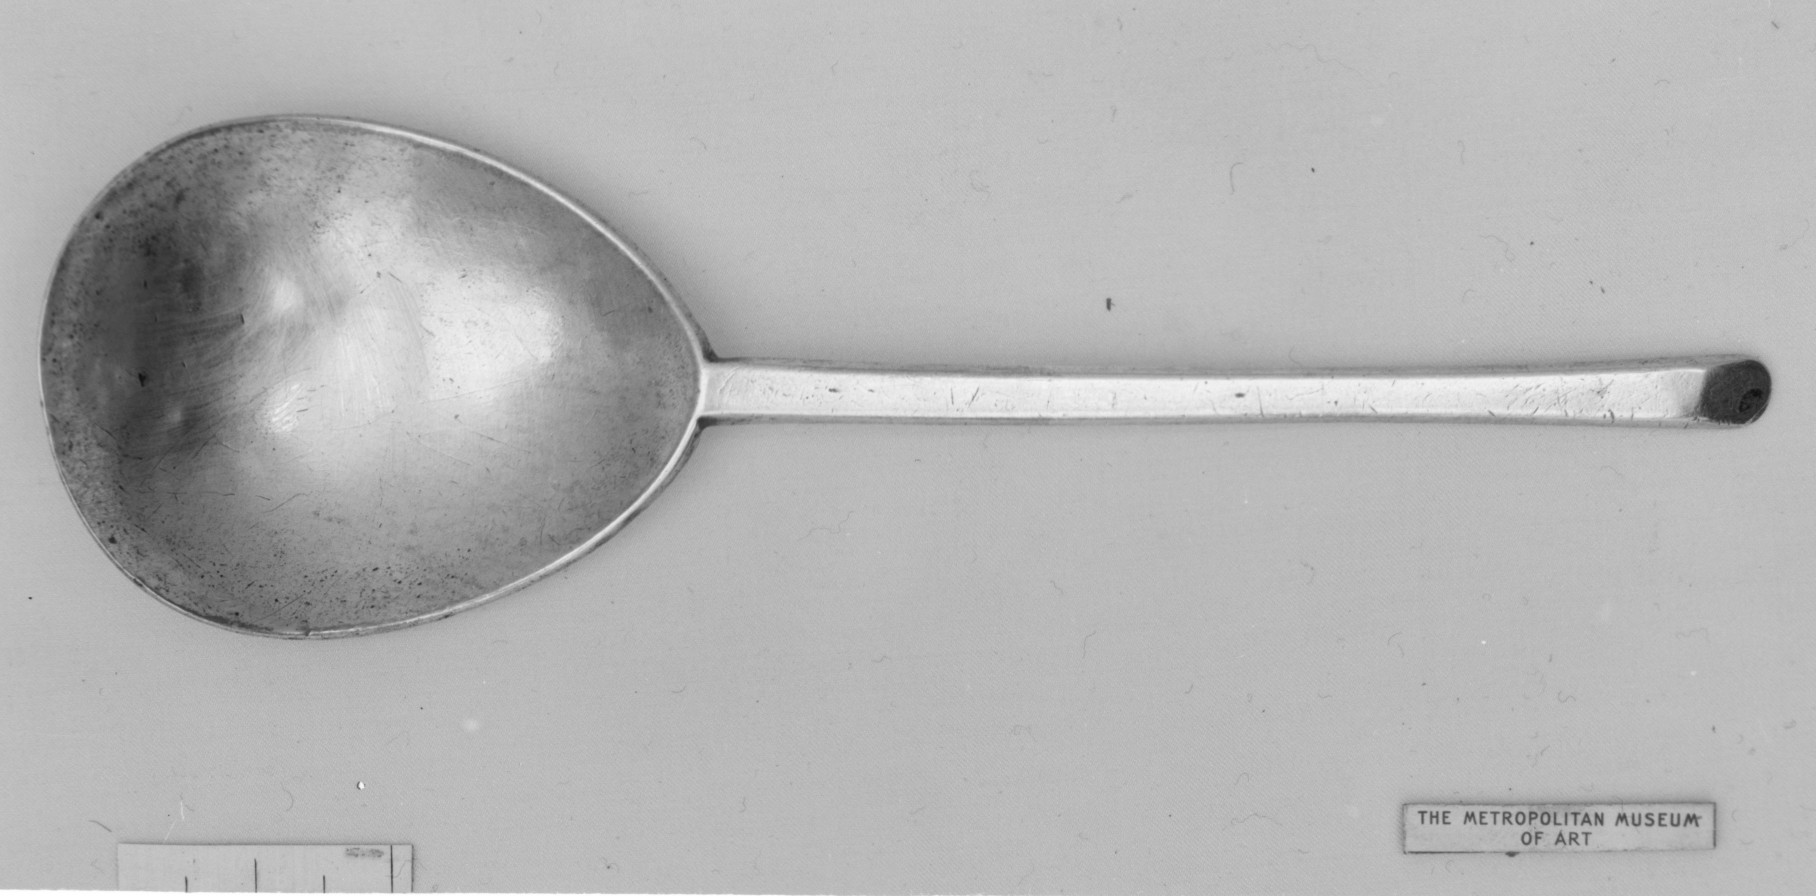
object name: spoon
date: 1640-1650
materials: silver